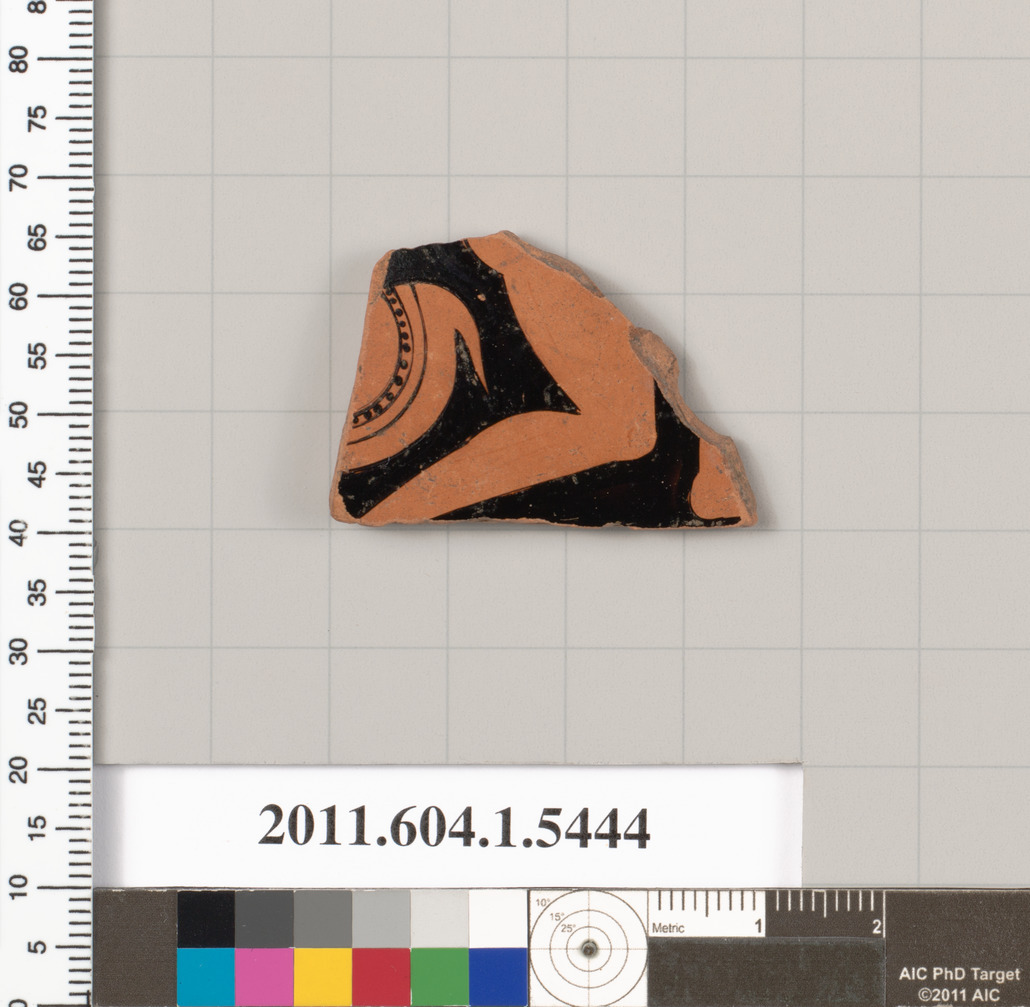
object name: kylix fragment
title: Terracotta fragment of a kylix (drinking cup)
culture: greek, attic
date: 500-490 BCE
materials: terracotta